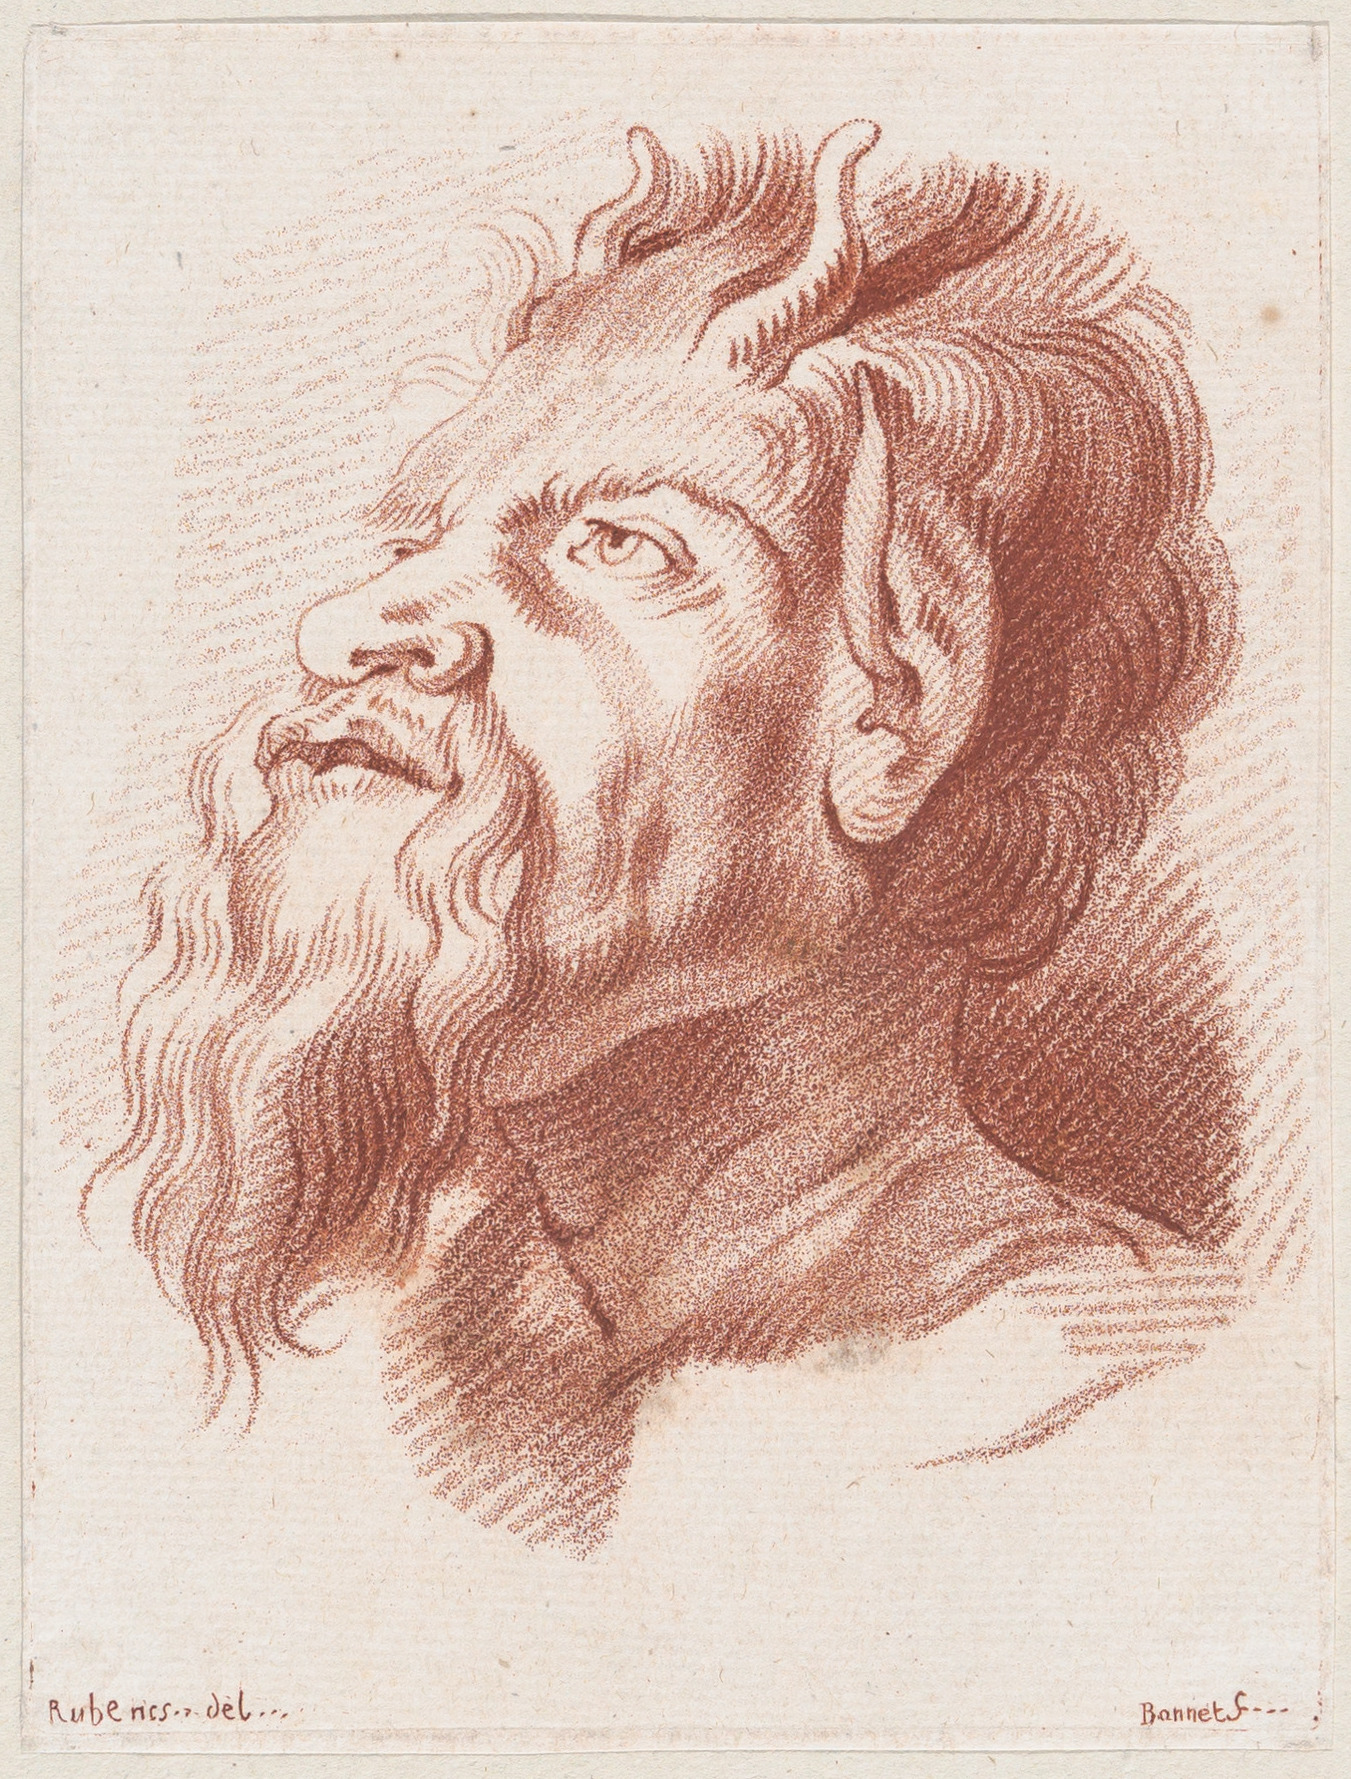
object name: print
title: Head of a satyr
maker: louis marin bonnet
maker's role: artist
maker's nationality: french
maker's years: 1736-1793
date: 1755-1793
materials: ink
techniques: printmaking, engraving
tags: satyrs